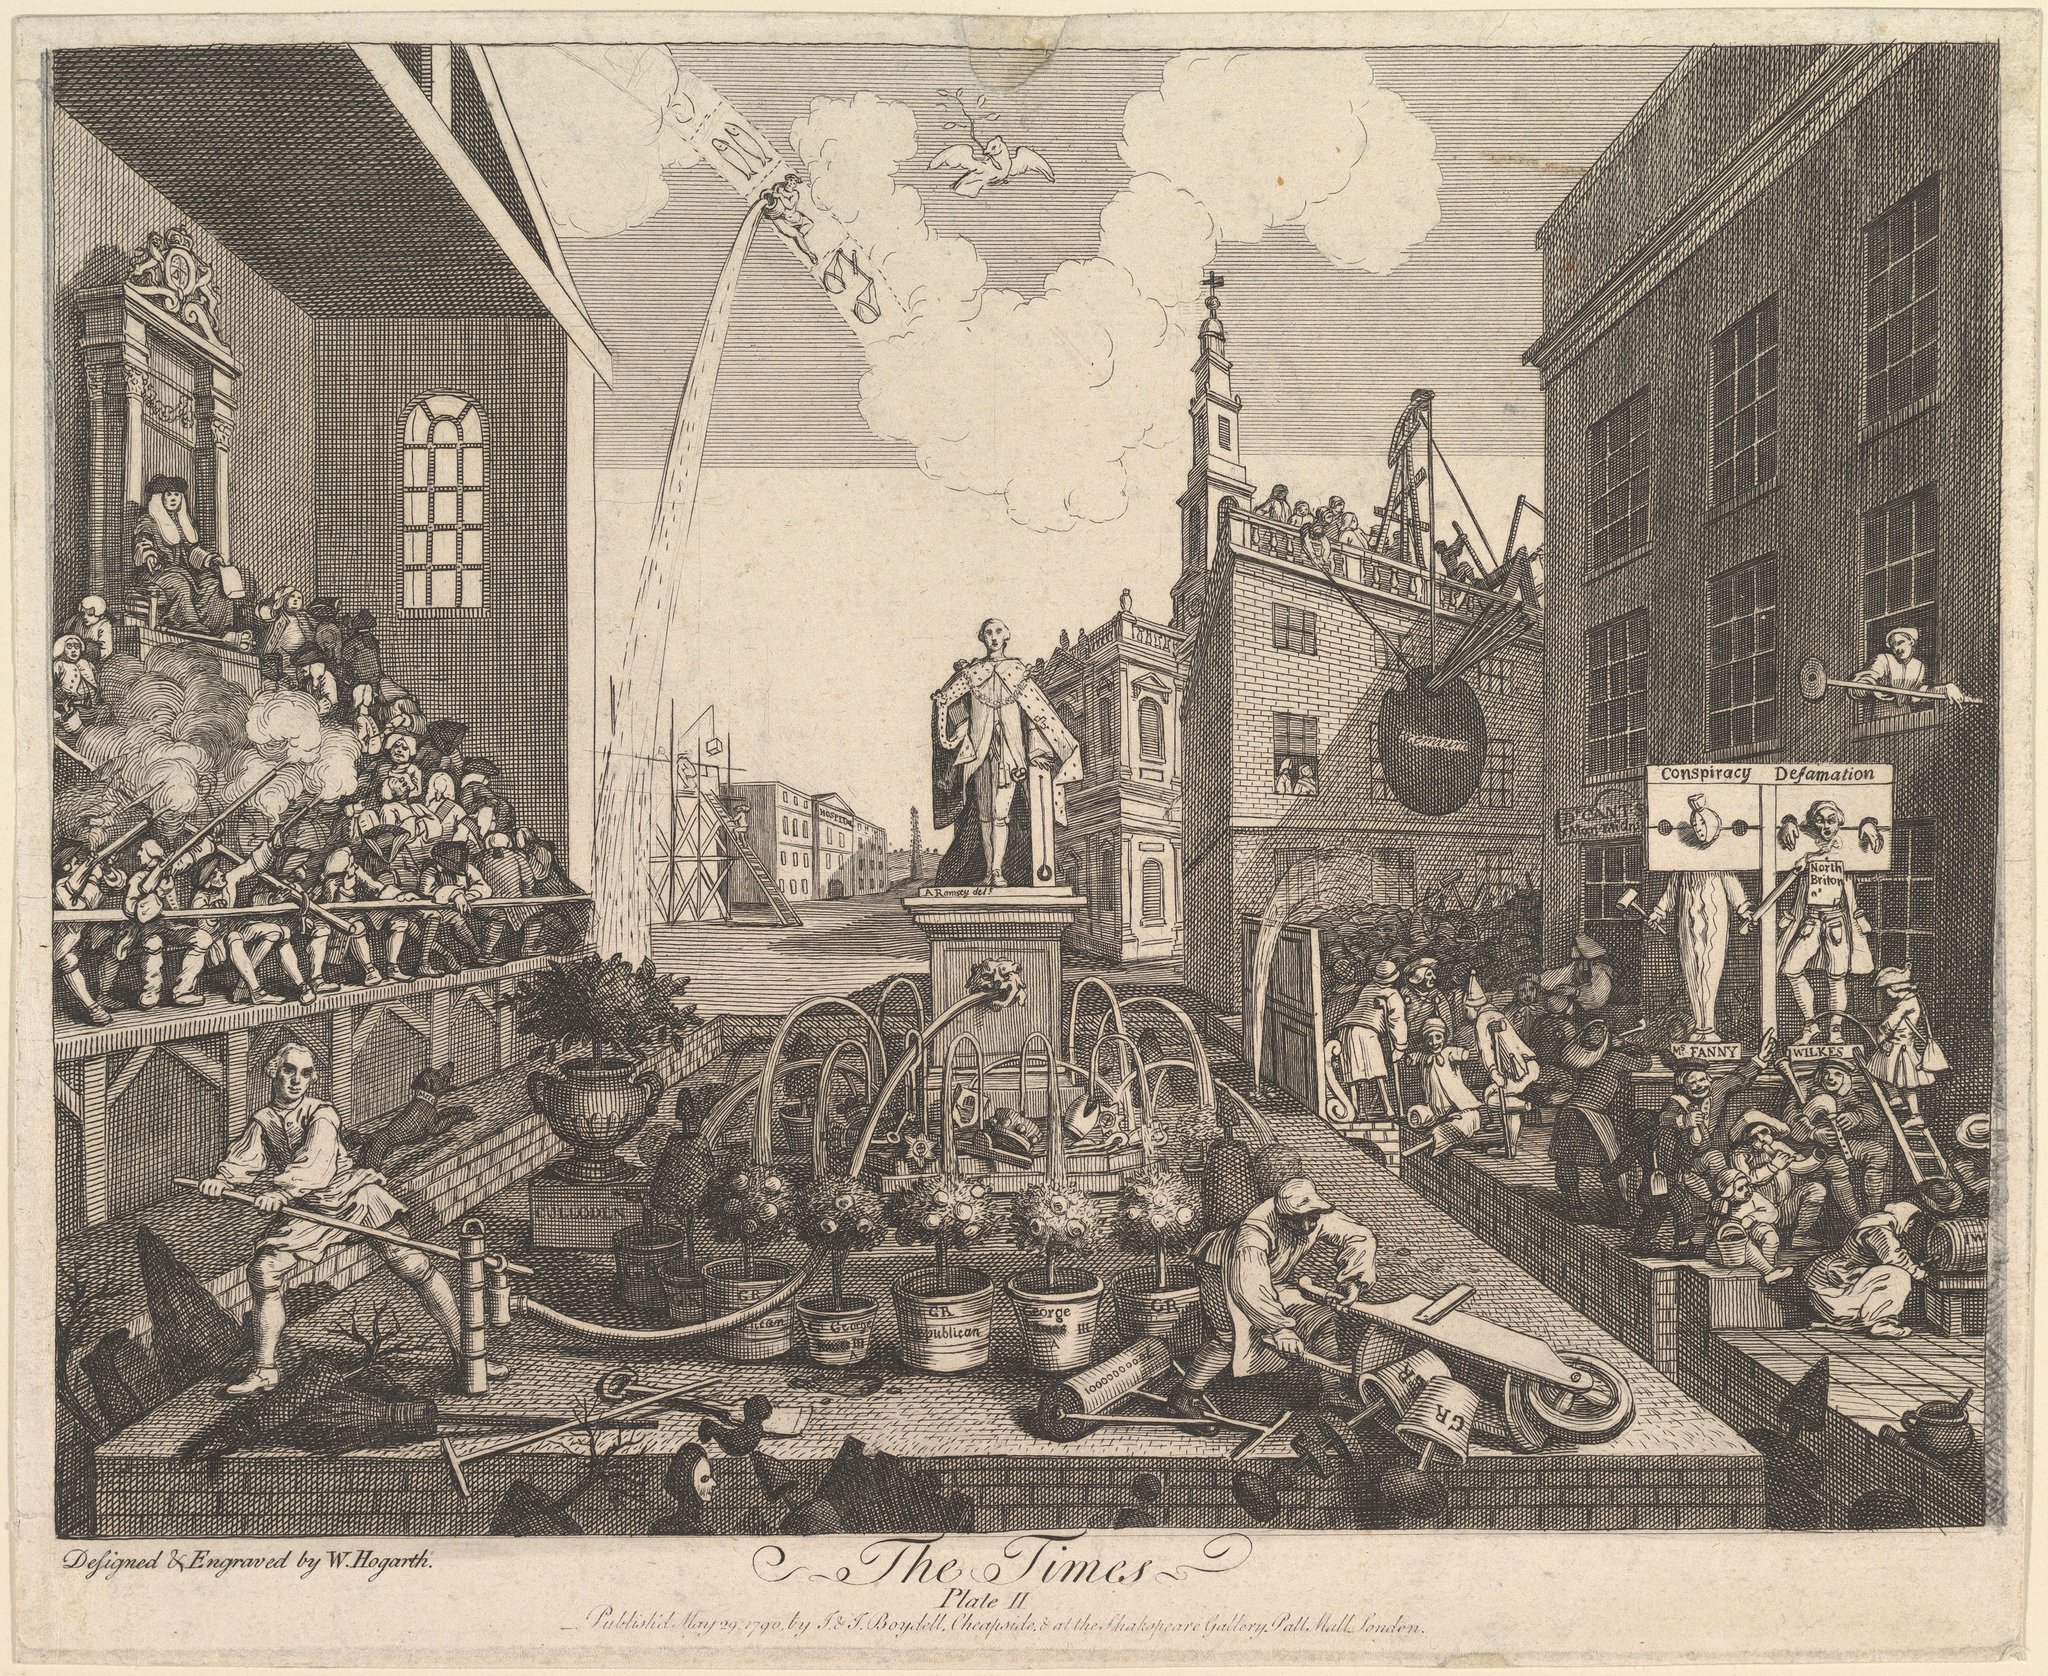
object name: print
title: The Times, Plate 2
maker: william hogarth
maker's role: artist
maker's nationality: british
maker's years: 1697-1764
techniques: engraving, etching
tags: satire,men,women,dogs